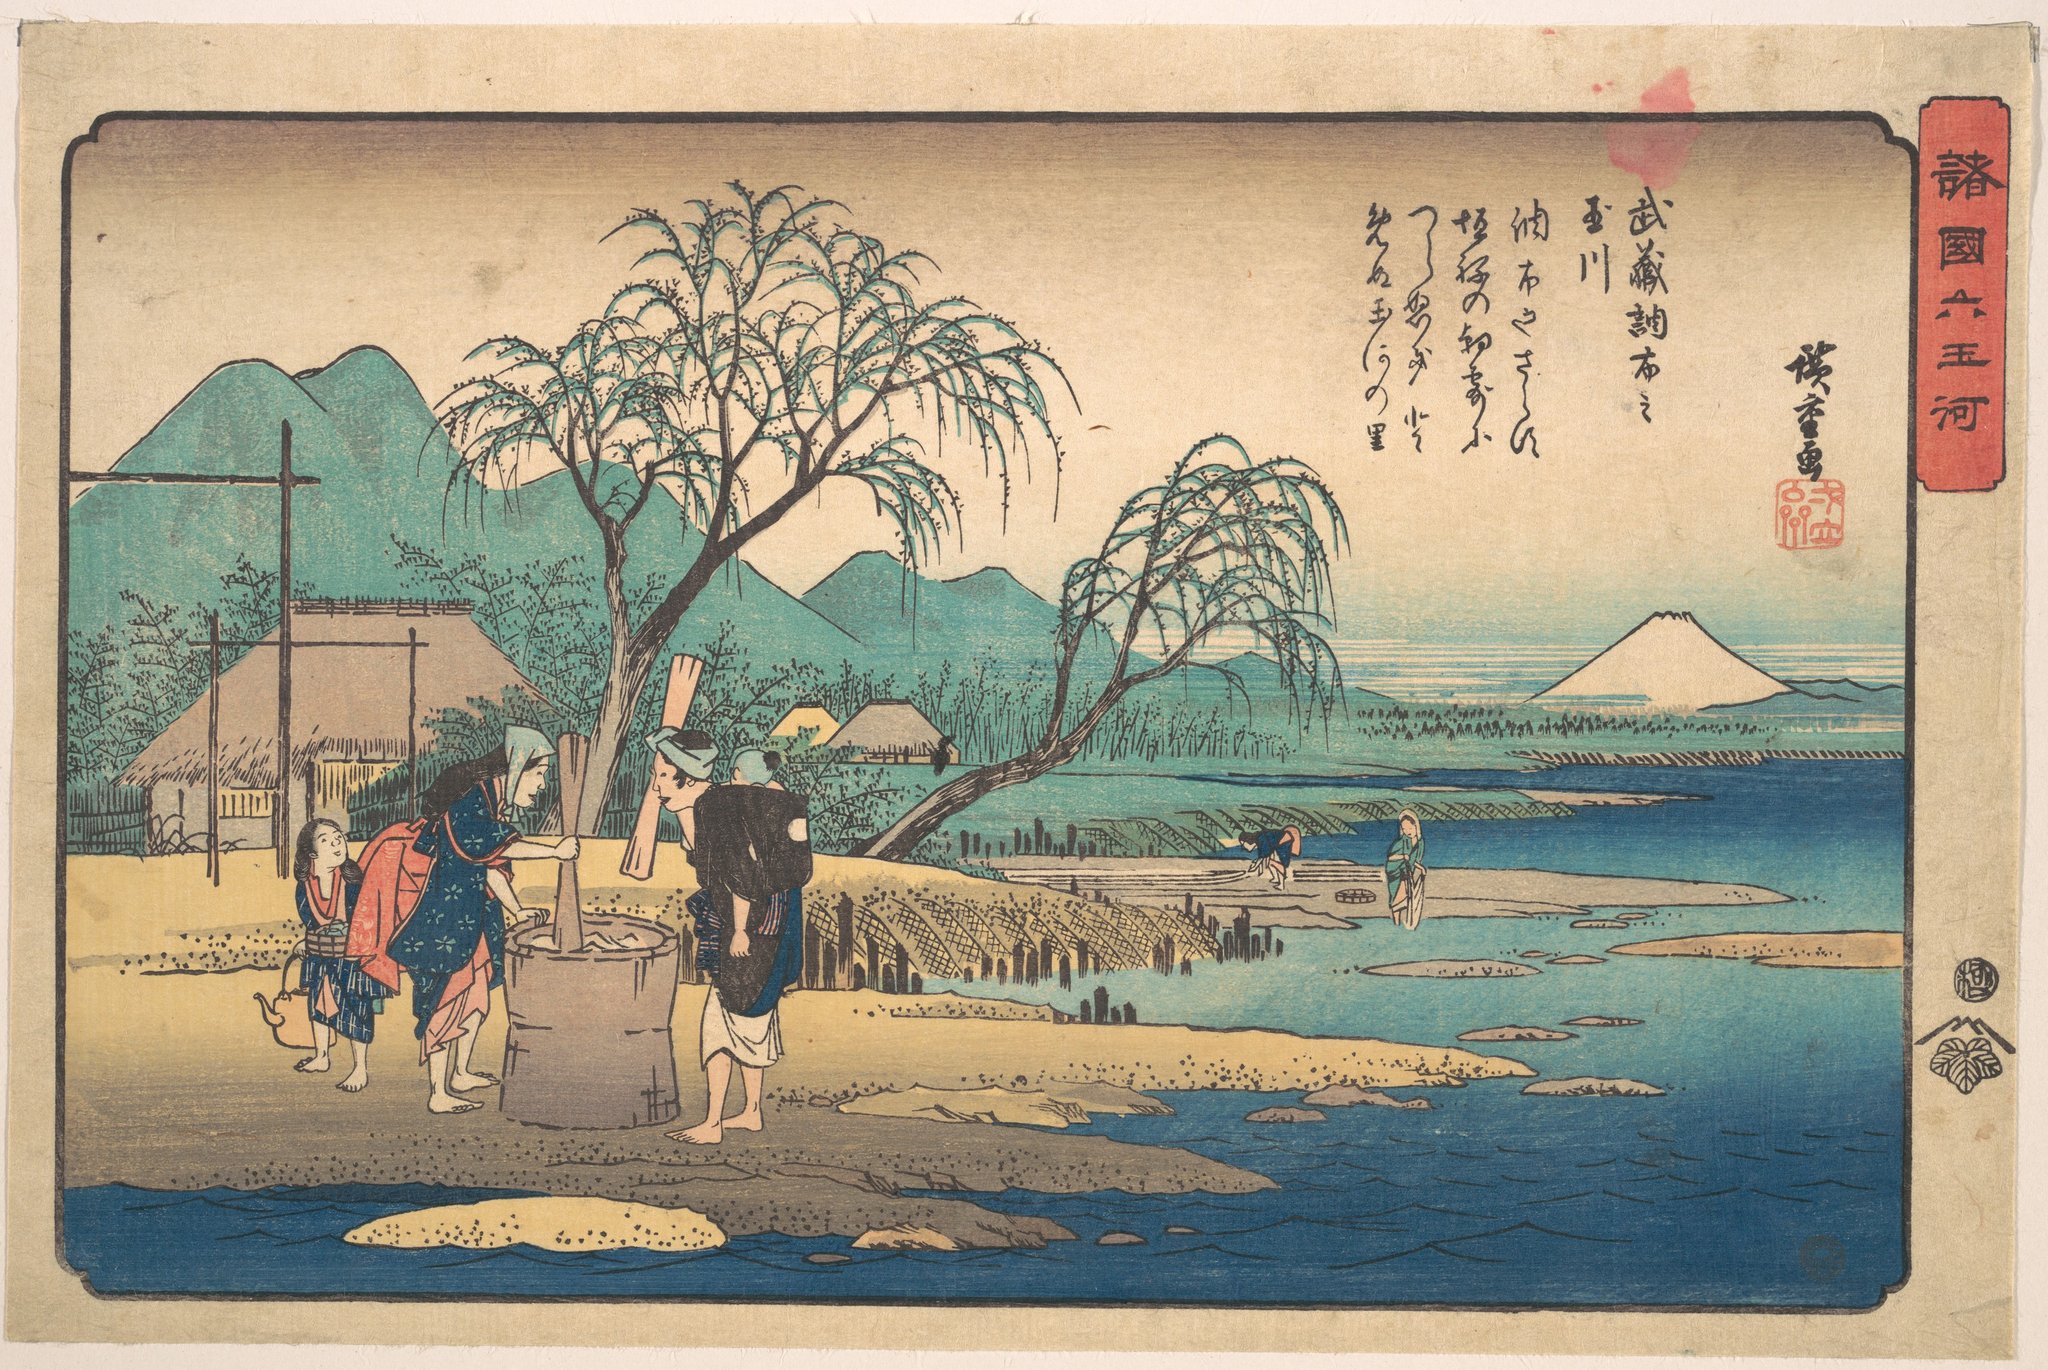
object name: print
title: Musashi: Chōfu no Tamagawa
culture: japanese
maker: utagawa hiroshige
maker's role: artist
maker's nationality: japanese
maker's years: 1797-1858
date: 1833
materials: ink, paper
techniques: woodblock print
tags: men,women,landscapes,working